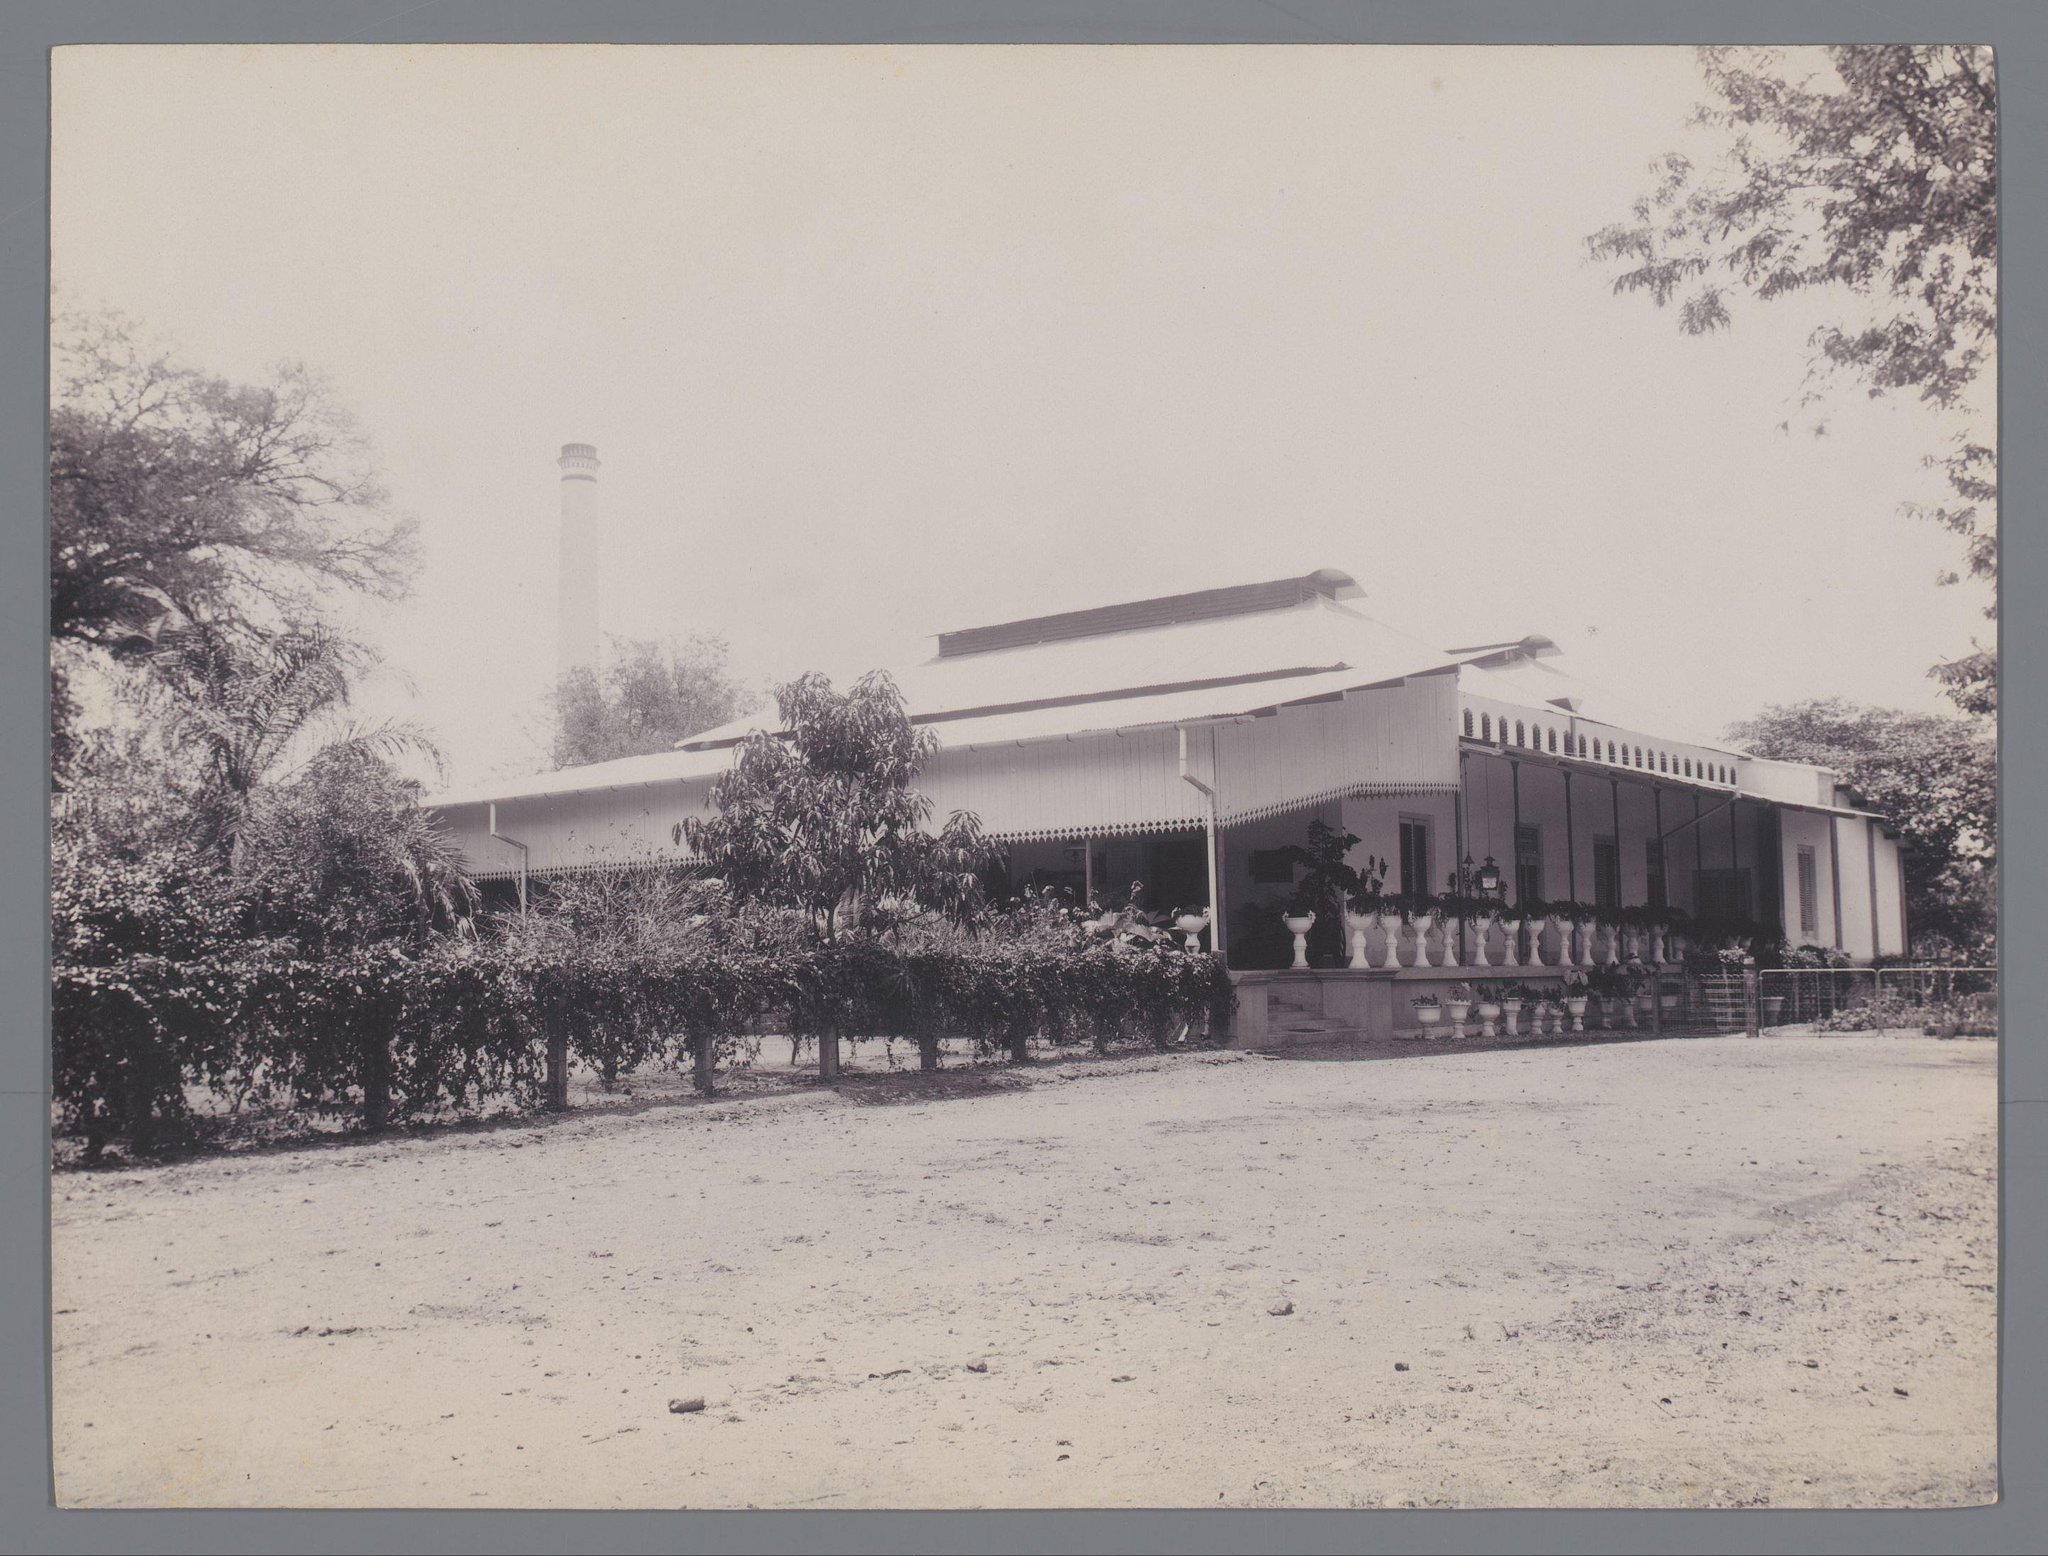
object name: photograph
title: Huis/bedrijf in Nederlands-Indië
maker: Anonymous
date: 1900-1920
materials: paper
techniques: albumen print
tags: dutch east indies, the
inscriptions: number: ‘No 22.’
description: Groot wit huis/bedrijf in Nederlands-Indië omringd door bomen en struikgewas. Een reeks potten met planten staan langs de veranda. Op de achtergrond een schoorsteen.